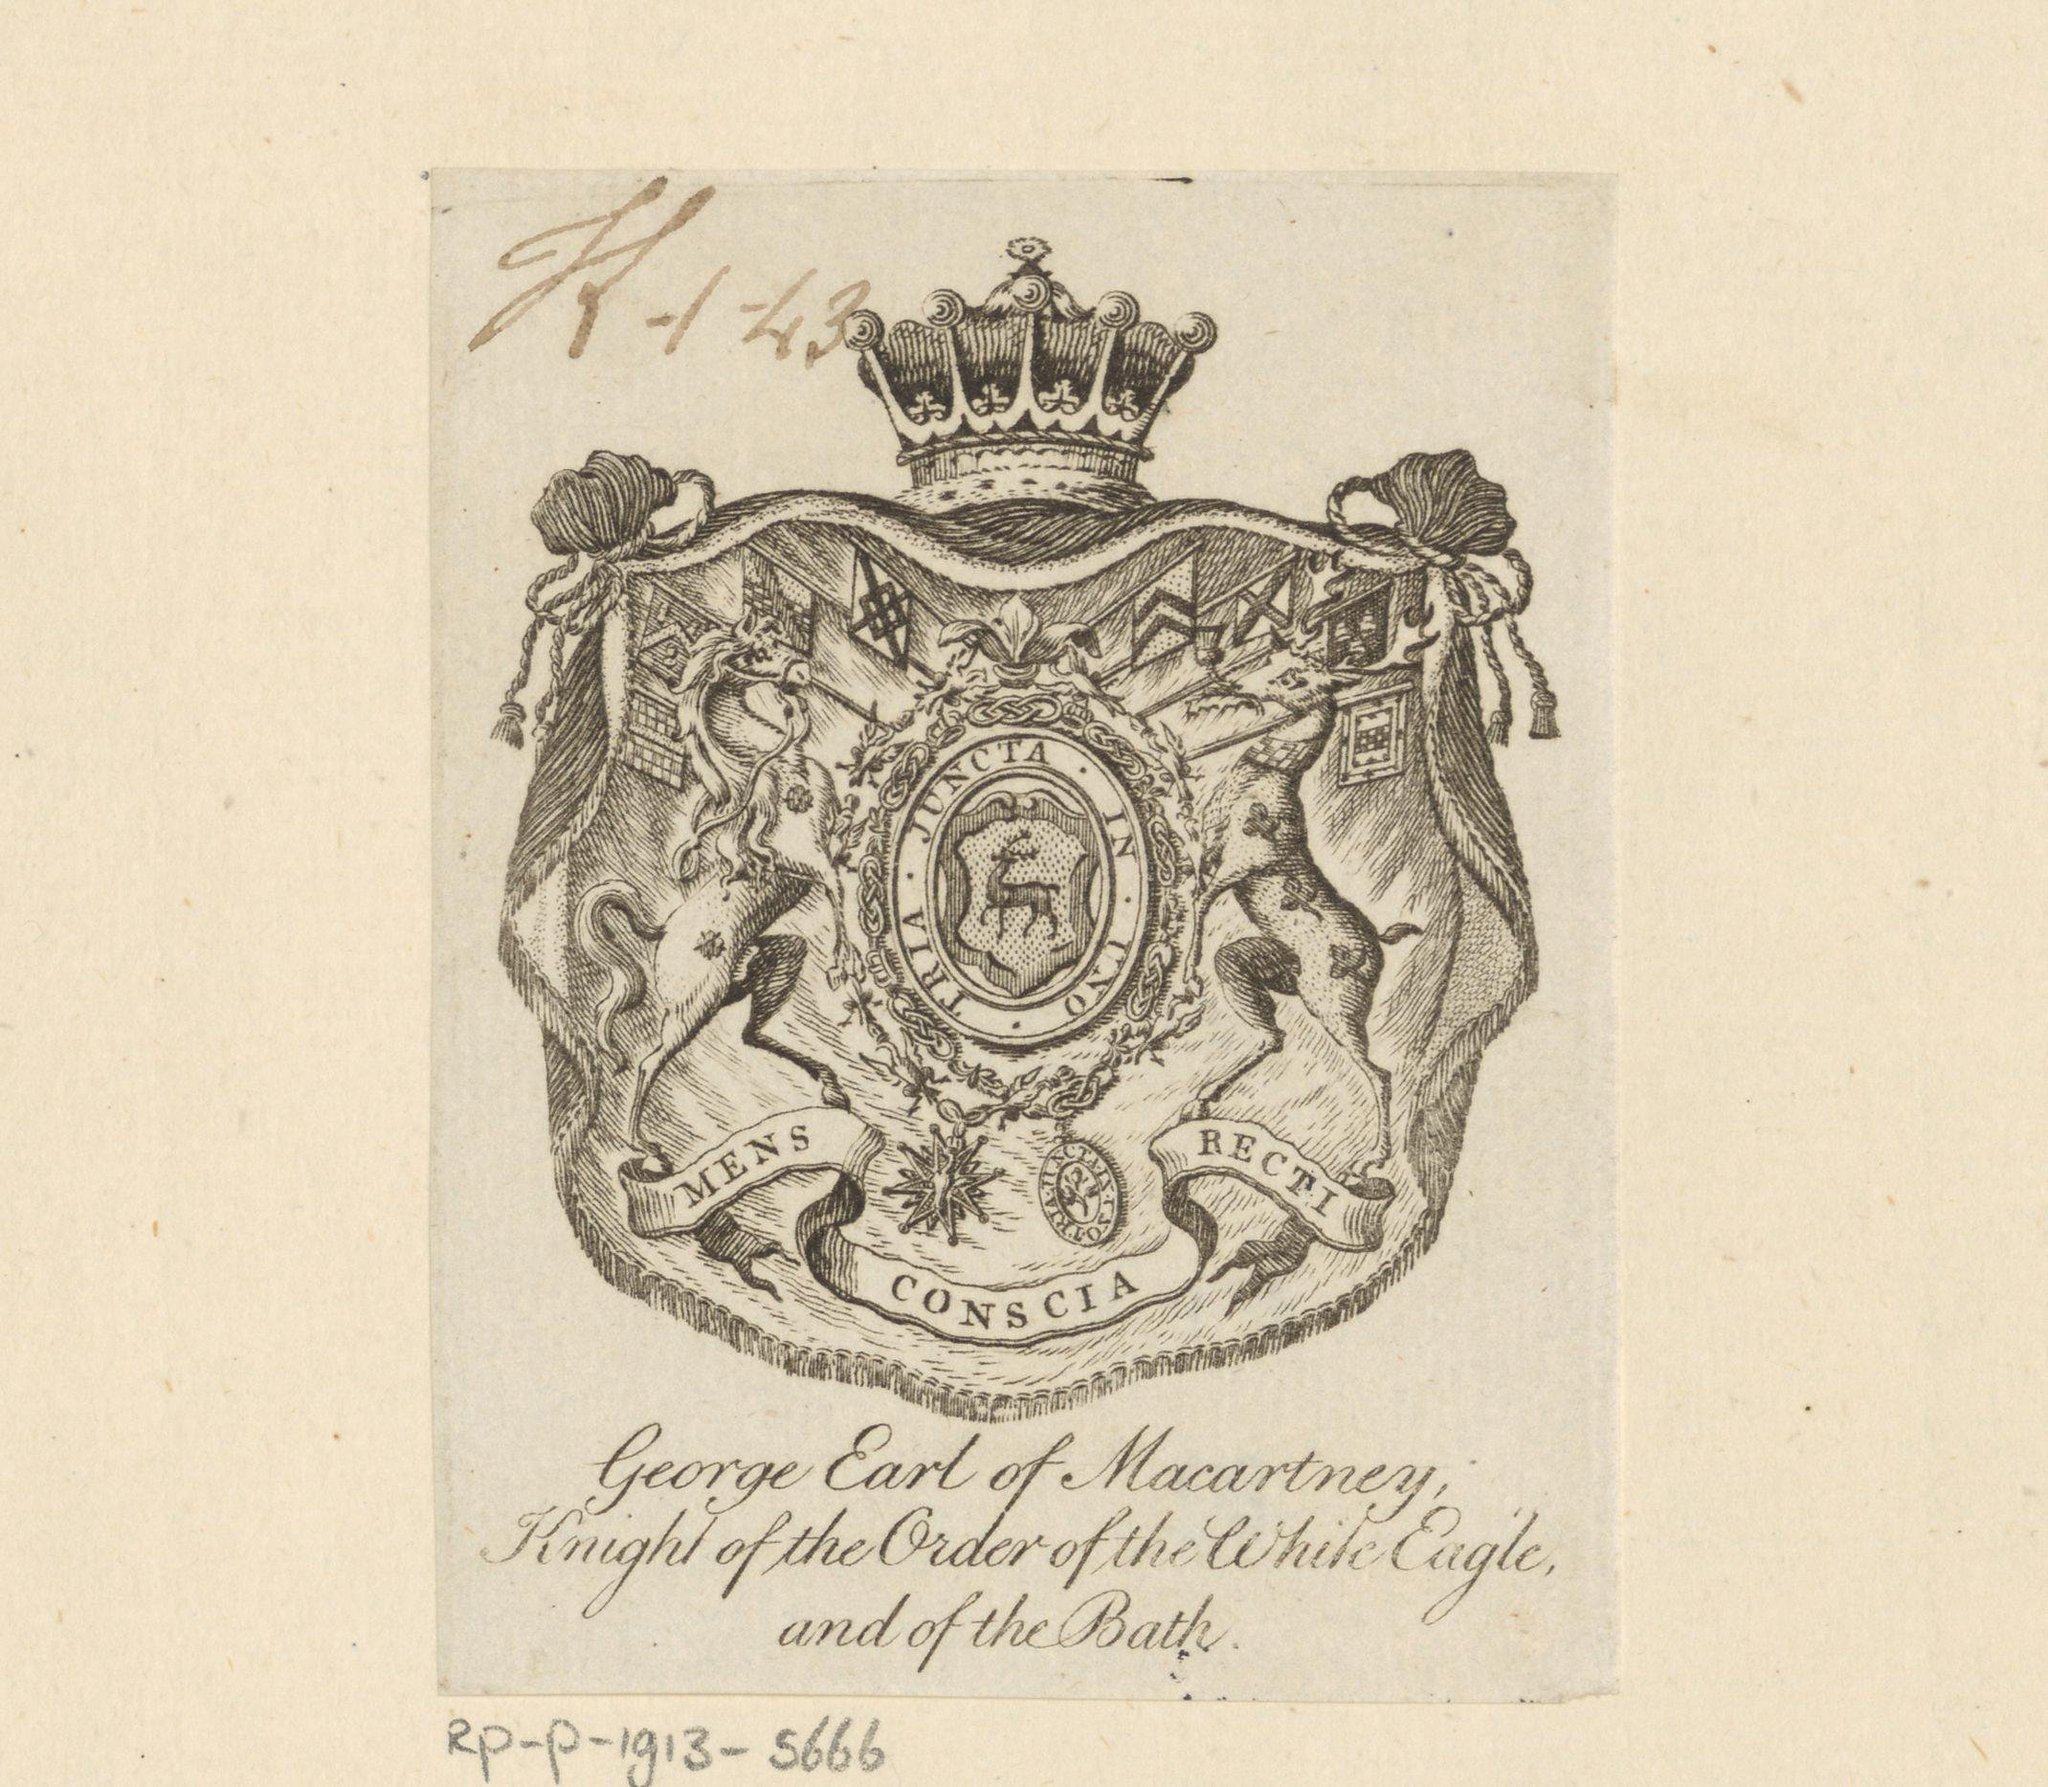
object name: bookplate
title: Ex libris van George Earl of Macartney, Knight of the Order of the White Eagle, and of the Bath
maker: Anonymous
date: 1747-1806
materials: paper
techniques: engraving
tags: armorial bearing, heraldry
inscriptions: collector's mark: Lugt 2233, collector's mark: Lugt 2760